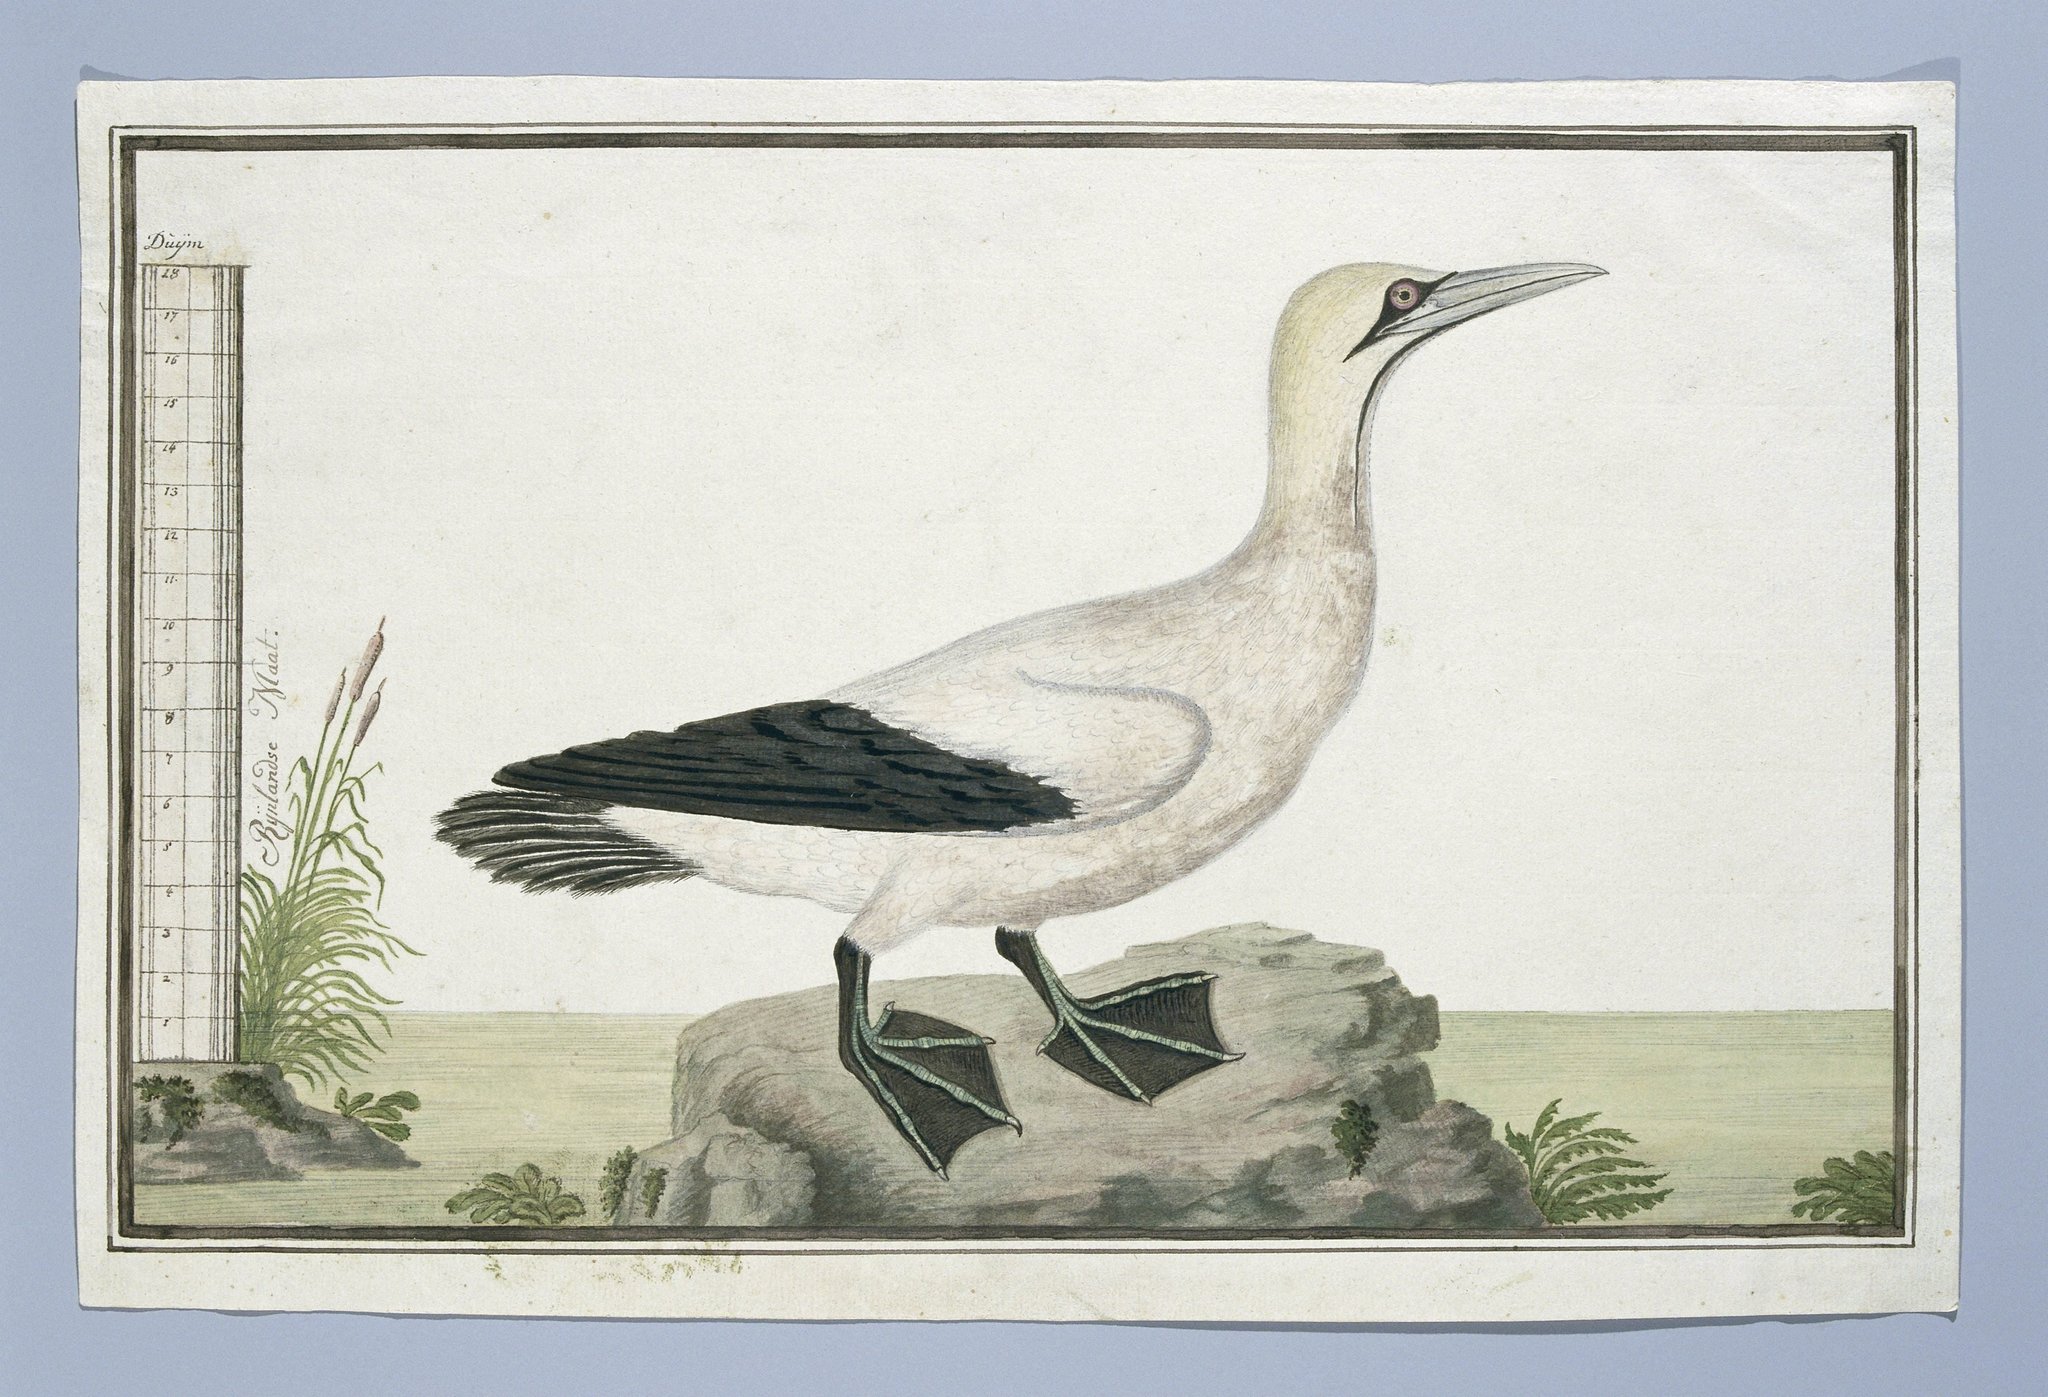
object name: album leaf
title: Morus capensis (Cape gannet)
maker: robert jacob gordon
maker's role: draughtsman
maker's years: 1743-1795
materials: chalk, ink, paper, pencil, watercolor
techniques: brush, pen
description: Vogelstudie: Kaapse Jan-van-Gent (Morus capensis); met schaalverdeling in Rijnlandse maat.